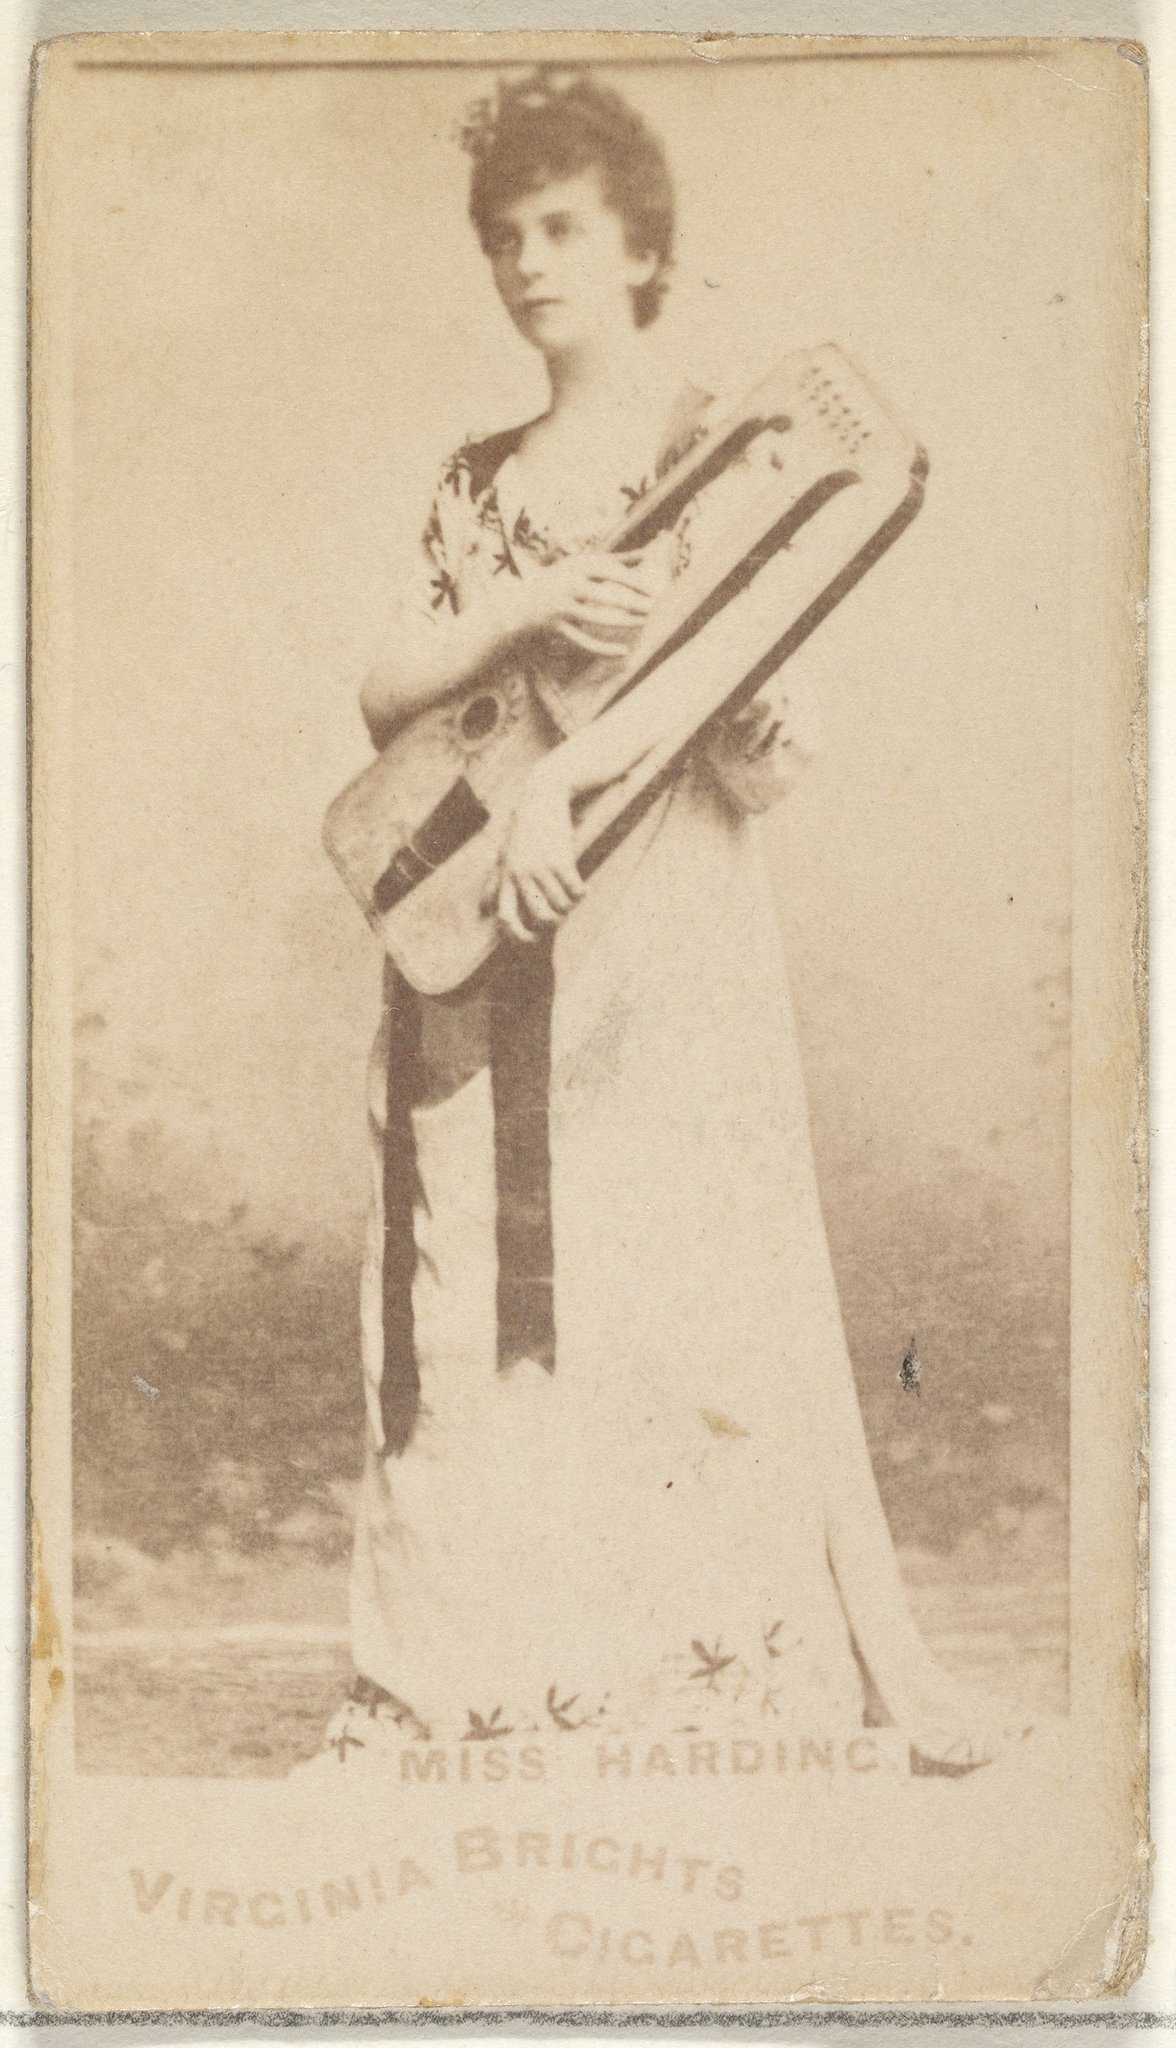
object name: photograph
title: Miss Harding, from the Actors and Actresses series (N45, Type 1) for Virginia Brights Cigarettes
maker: allen & ginter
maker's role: publisher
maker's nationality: american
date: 1888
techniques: albumen silver print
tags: portraits,women,actresses